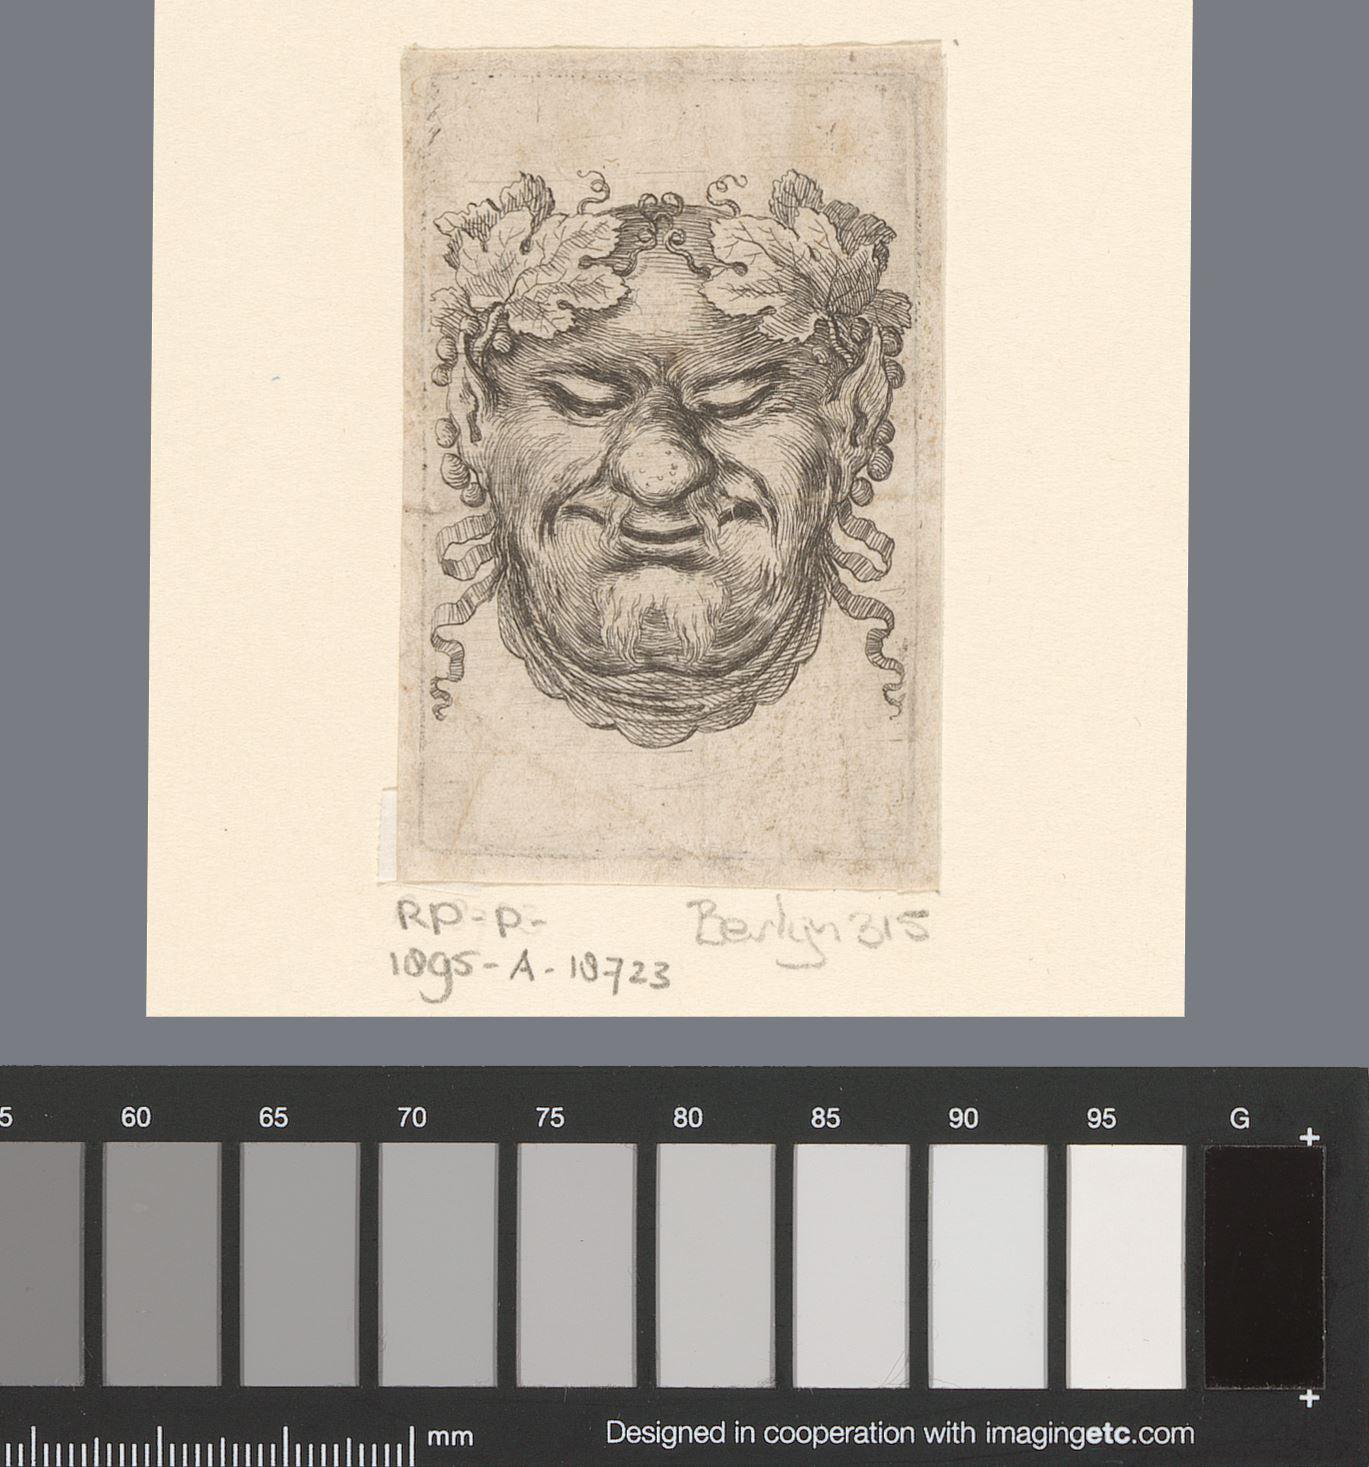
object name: print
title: Divers Masques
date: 1626-1676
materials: paper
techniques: etching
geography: paris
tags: mask, mascaron ~ ornament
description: Prent is onderdeel van een serie van achttien.